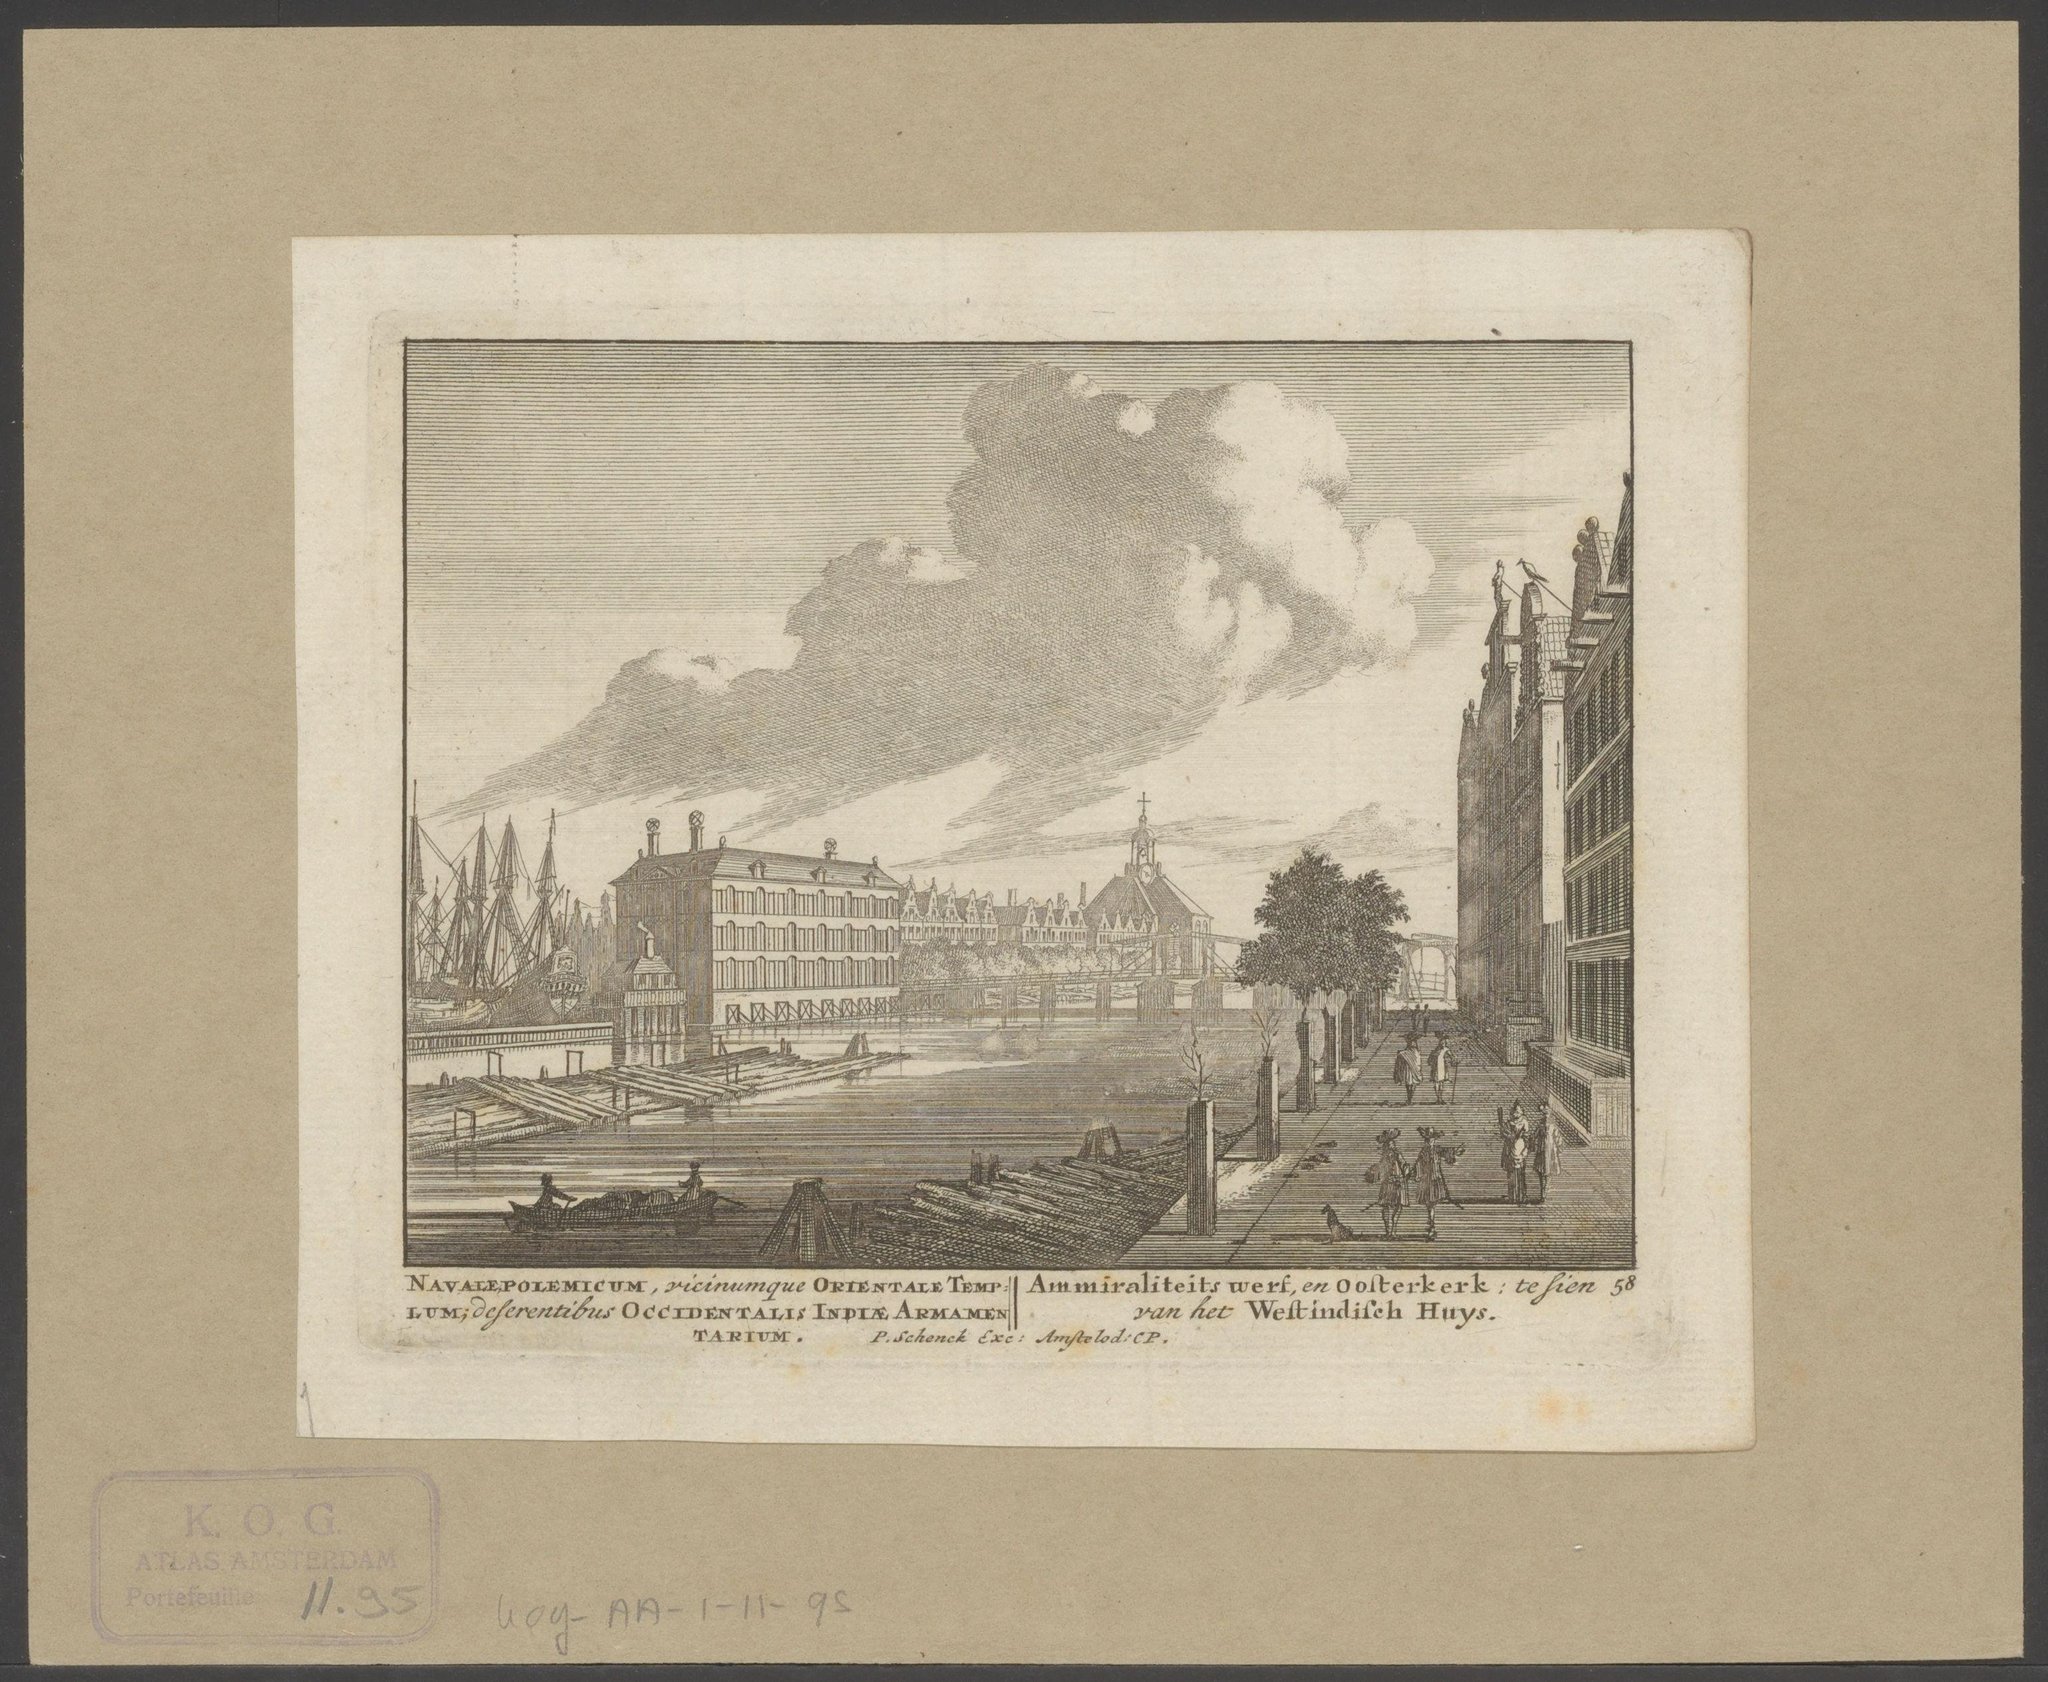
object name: print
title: Admirandorum Quadruplex Spectaculum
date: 1694-1697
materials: paper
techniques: etching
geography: amsterdam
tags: city-view in general; 'veduta', river, bridge in city across river, canal, etc., street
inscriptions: collector's mark: ‘11.95’ Lugt 1641b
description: Prent gebruikt in: Call, Jan van. Admirandorum Quadruplex Spectaculum. Amsterdam: Pieter Schenk (I), 1700. De titelprent, opdracht en het portret van Frederik van Saksen zijn gegraveerd door Pieter Schenk (I). De overige prenten uit deze serie zijn, zoals aangegeven op de titelprent, van de hand van Jan van Call (I).